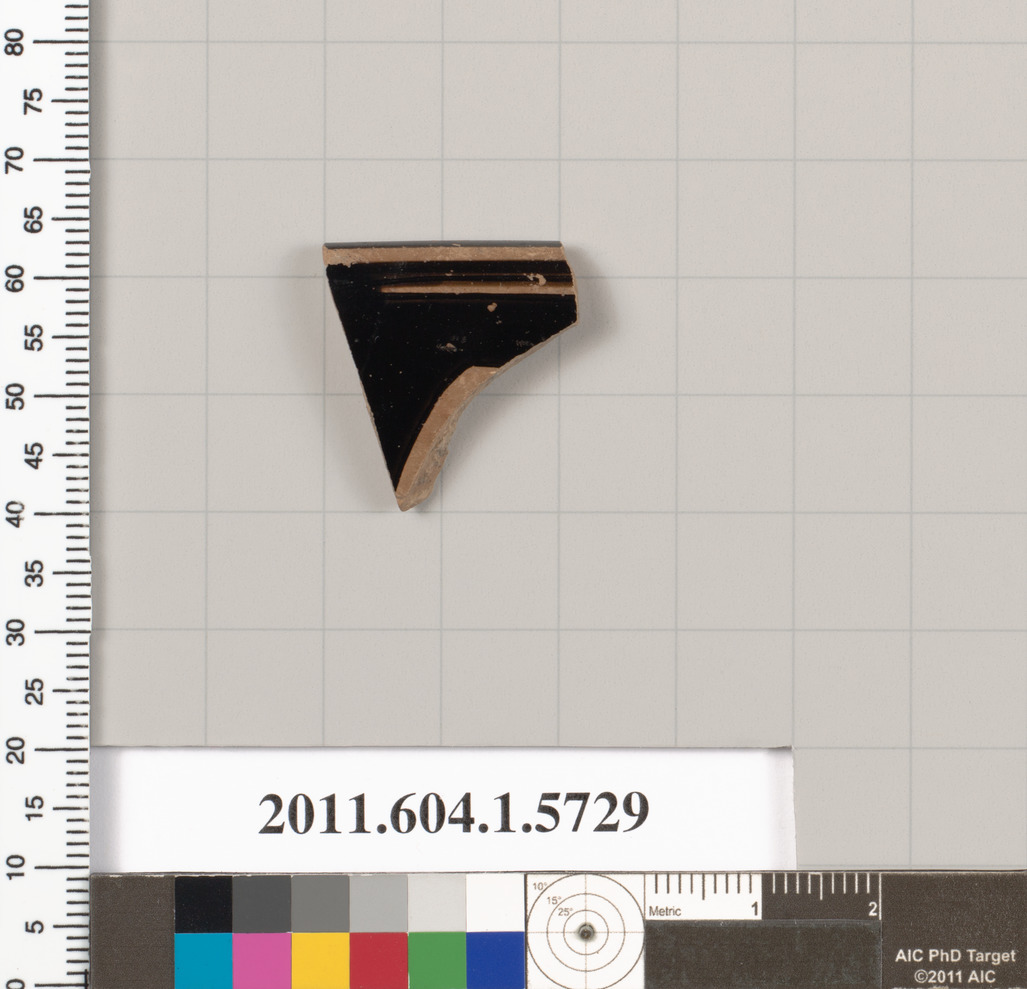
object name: kylix fragment, eye cup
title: Terracotta rim fragment of a kylix: eye-cup (drinking cup)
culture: greek, attic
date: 520-510 BCE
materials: terracotta